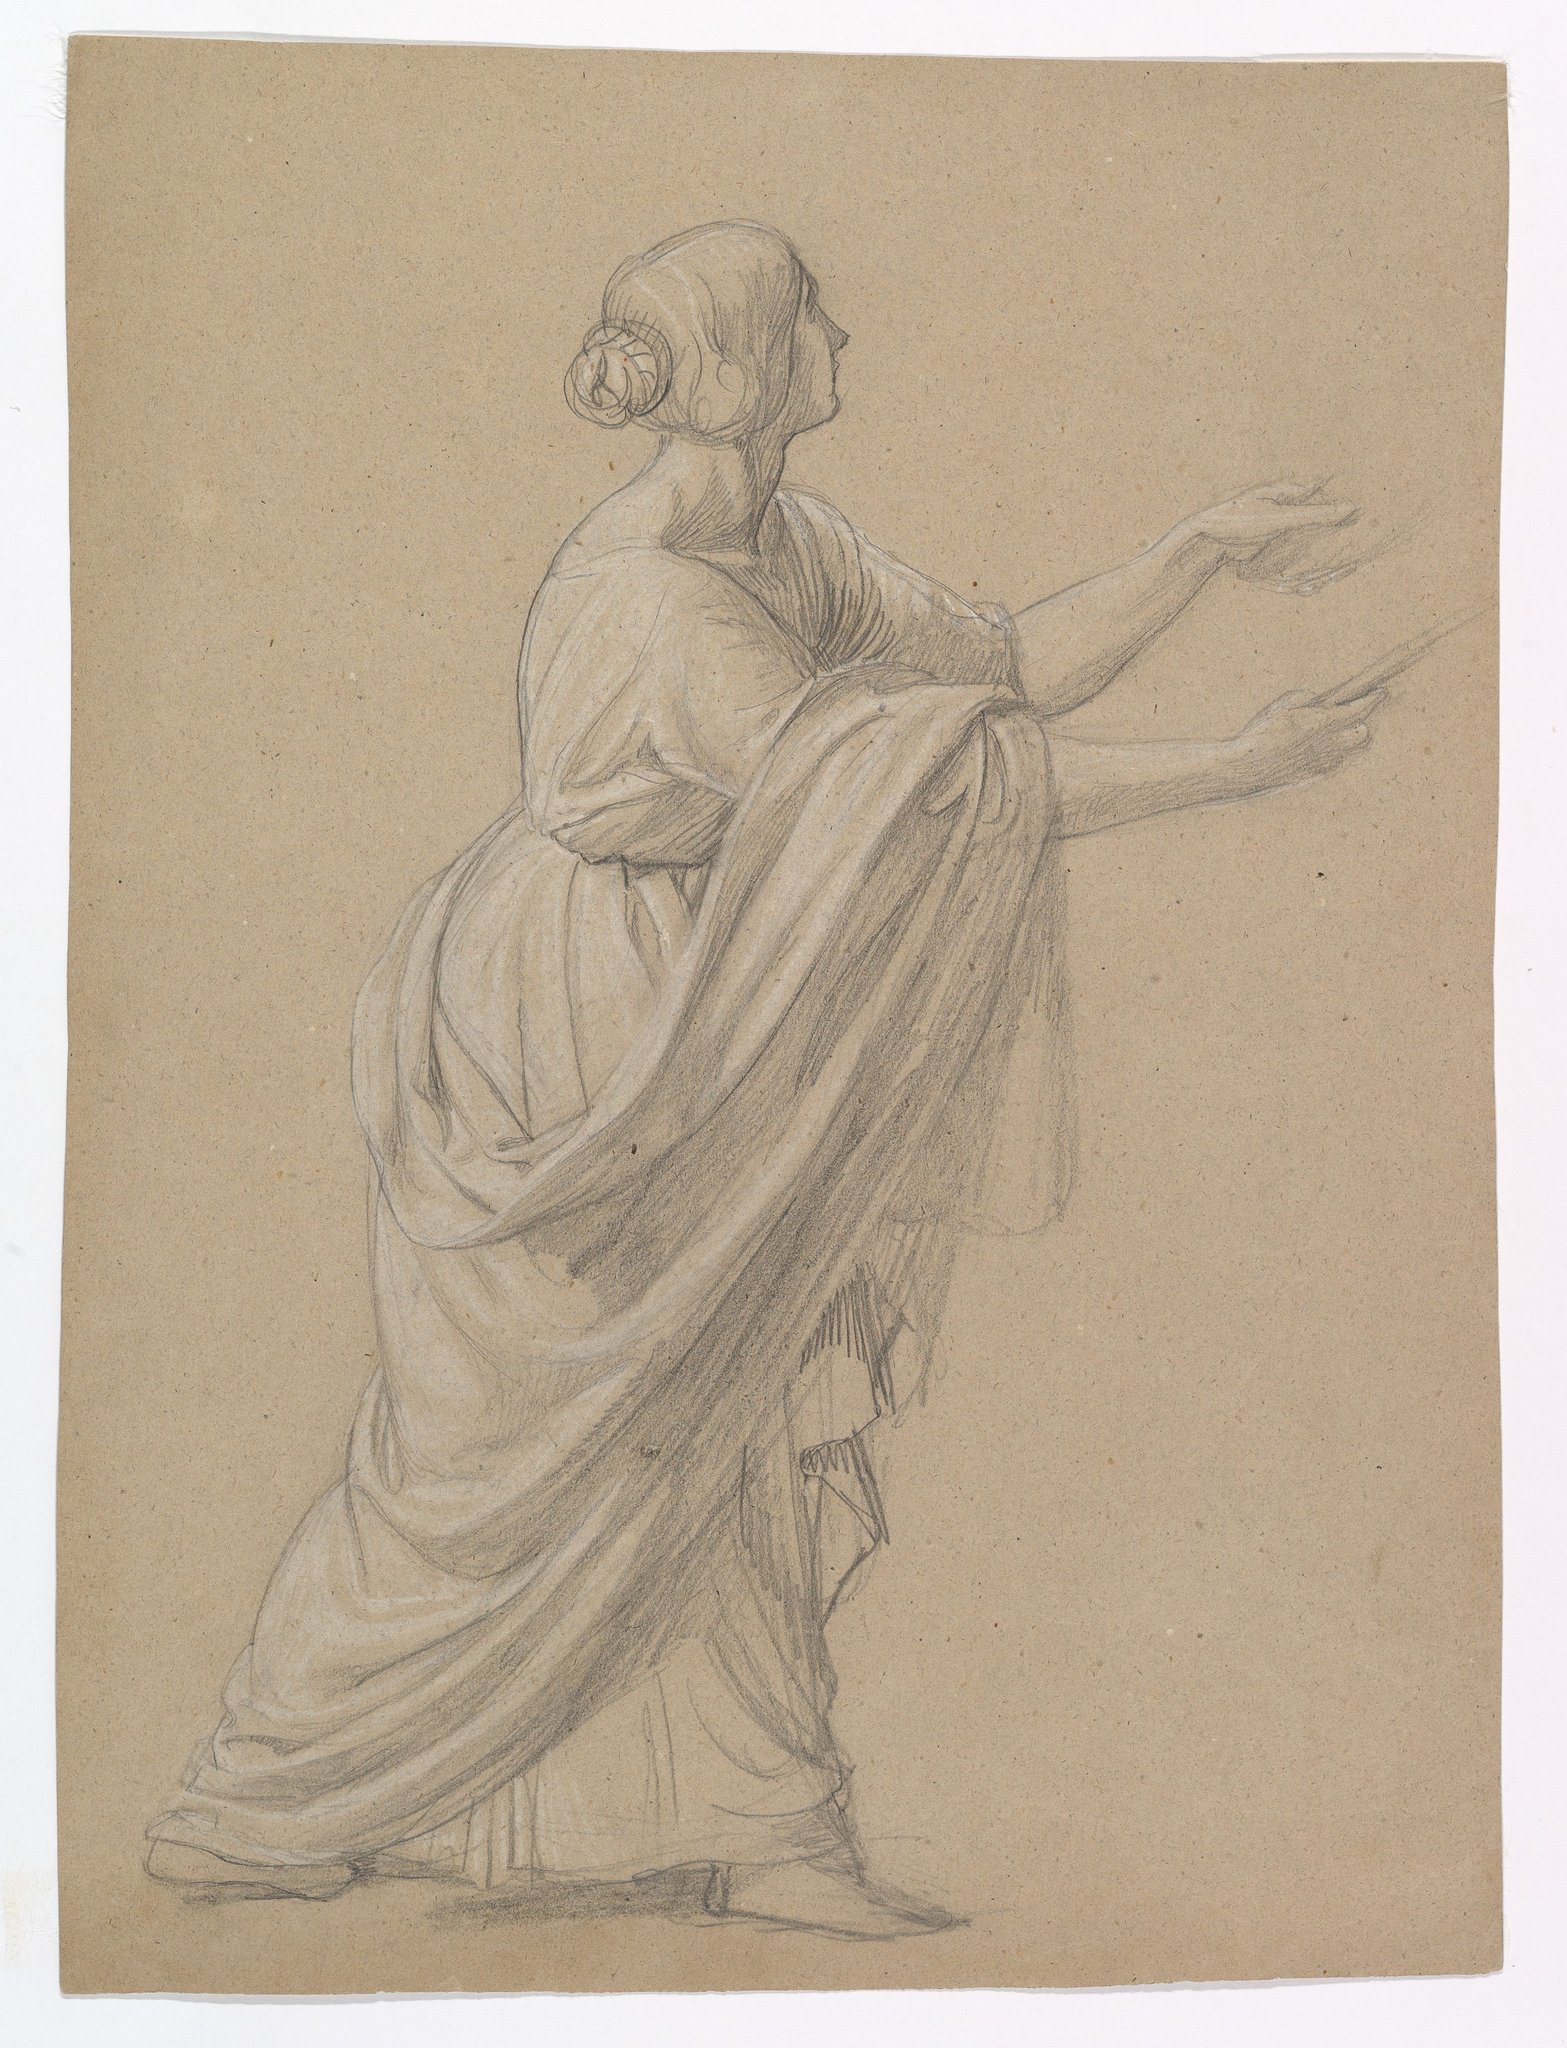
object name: drawing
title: Study of a Woman Walking to the Right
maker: wilhelm schadow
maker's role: artist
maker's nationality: german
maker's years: 1788-1862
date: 1808-1862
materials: chalk, graphite, paper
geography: germany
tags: women,walking